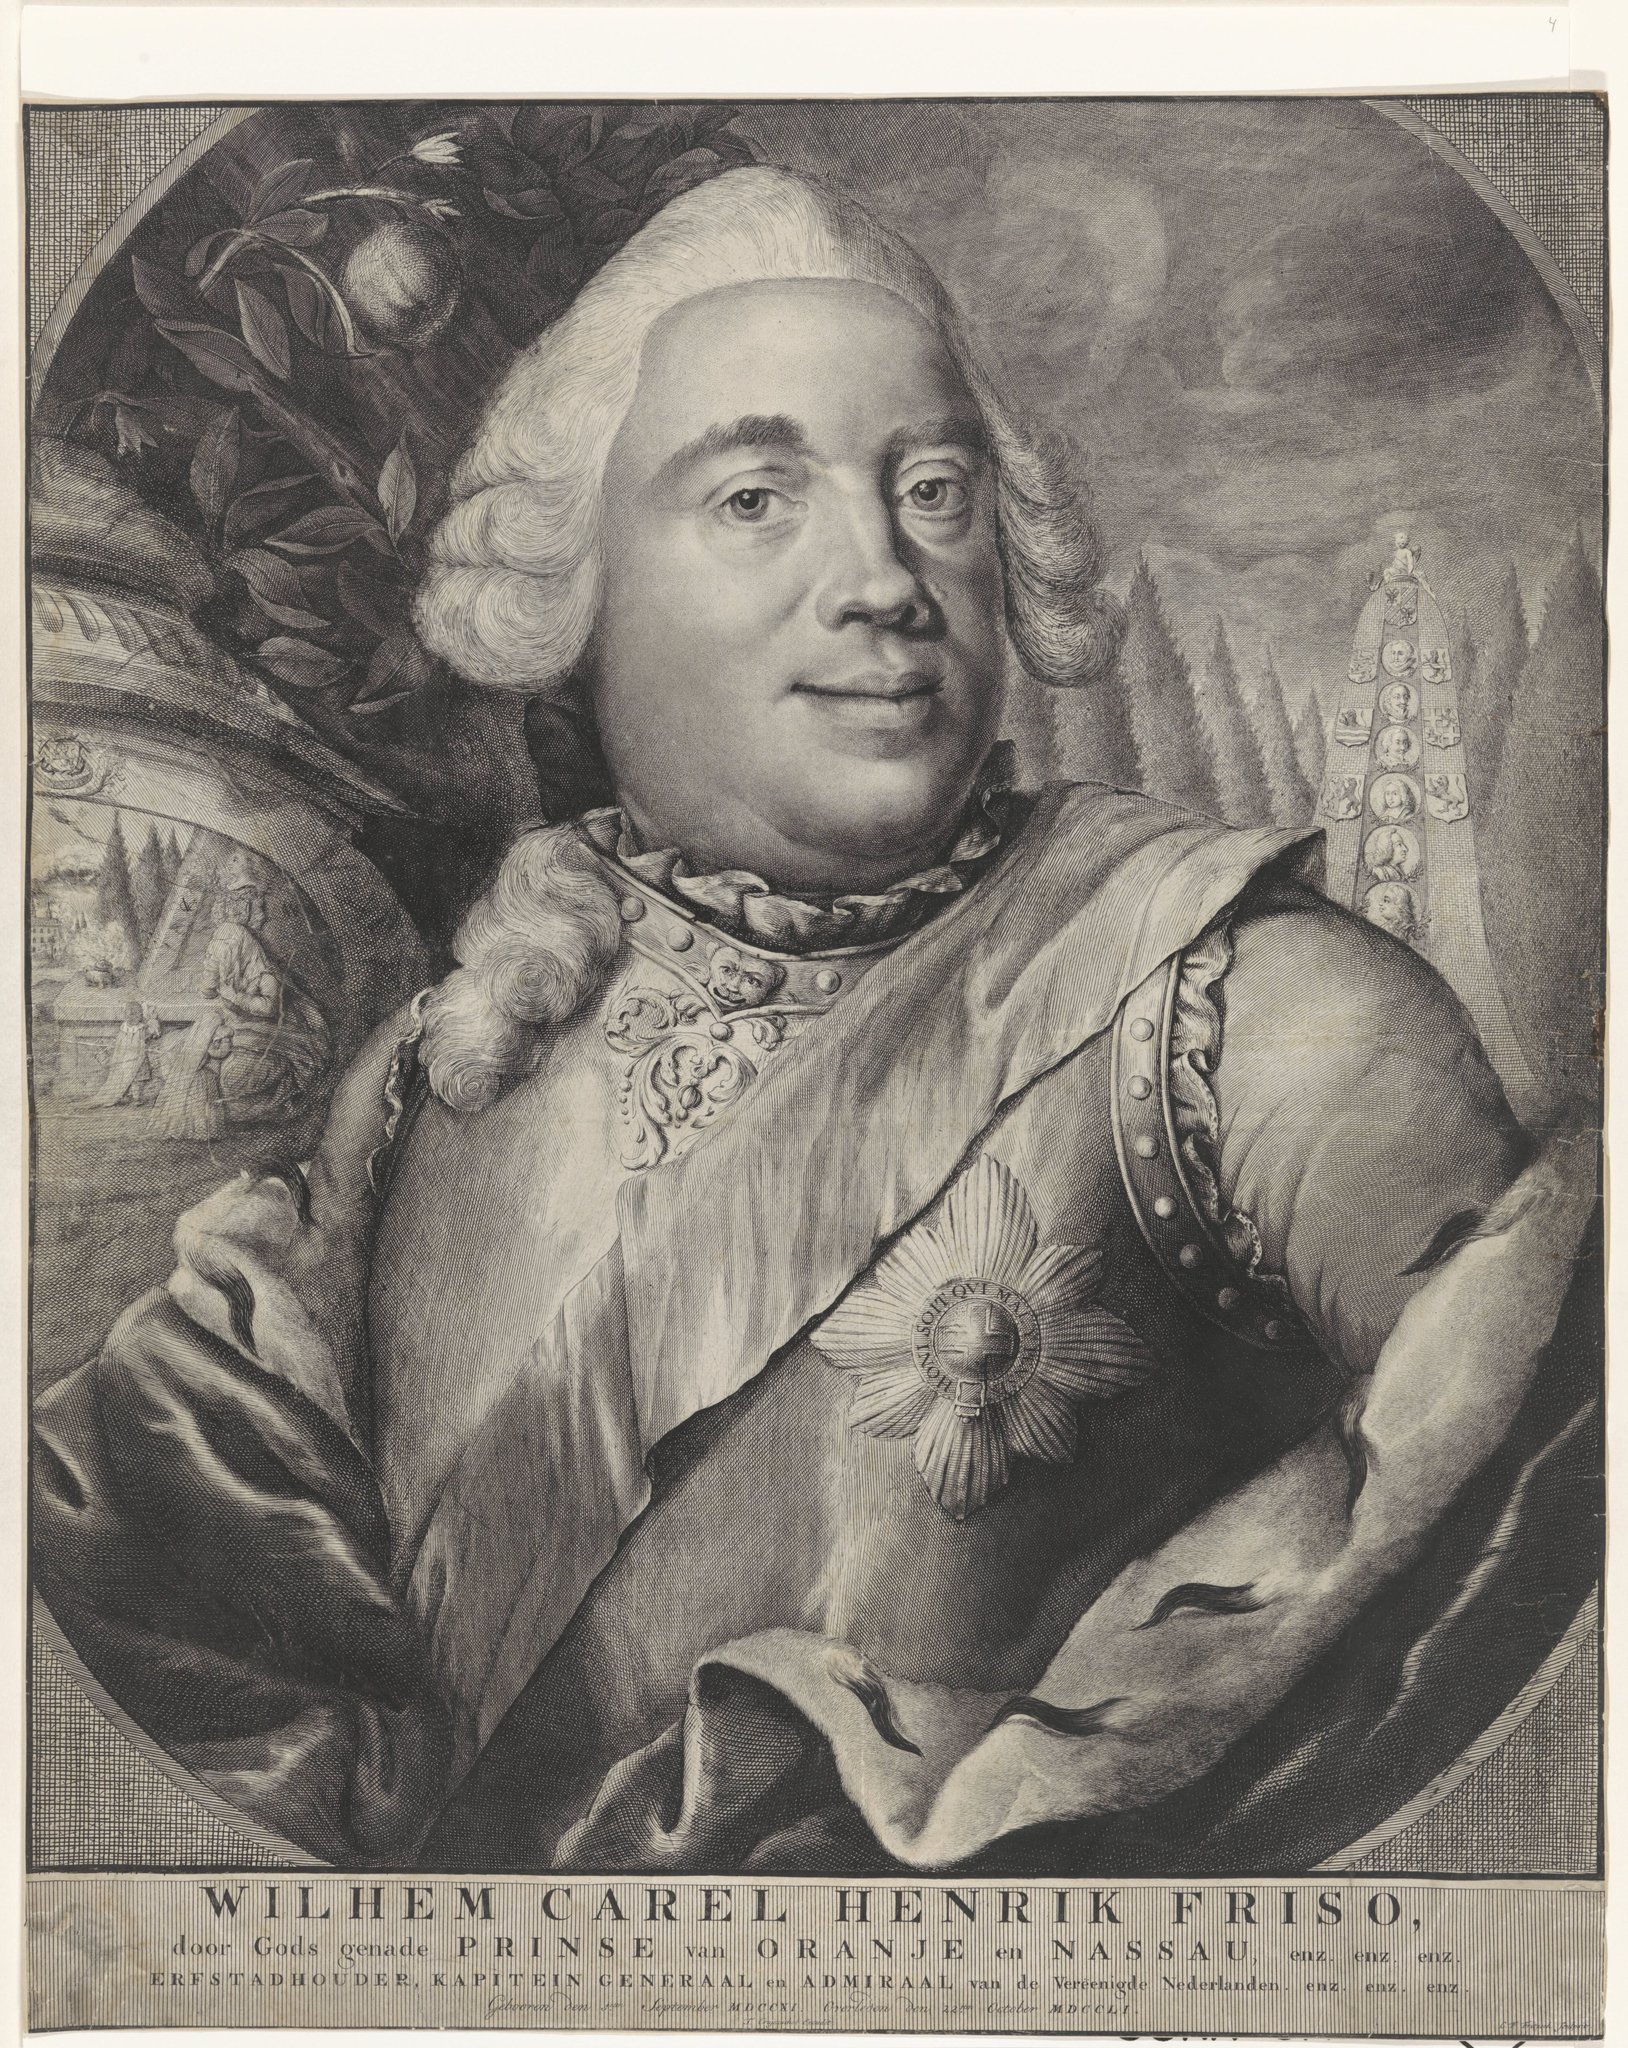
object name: print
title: Portret van Willem IV, prins van Oranje-Nassau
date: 1751-1774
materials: paper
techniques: engraving, etching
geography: amsterdam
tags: the hague, willem iv (prins van oranje-nassau)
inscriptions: collector's mark: Lugt 2228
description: Portret van Willem IV, prins van Oranje-Nassau. Rechts op de achtergrond een zuil met de wapenschilden en portretten van zijn voorvaderen, met bovenop een putto. Links een afbeelding van een treurende vrouw en twee kinderen bij een grafmonument met een rokende pot, als toespeling op zijn dood.